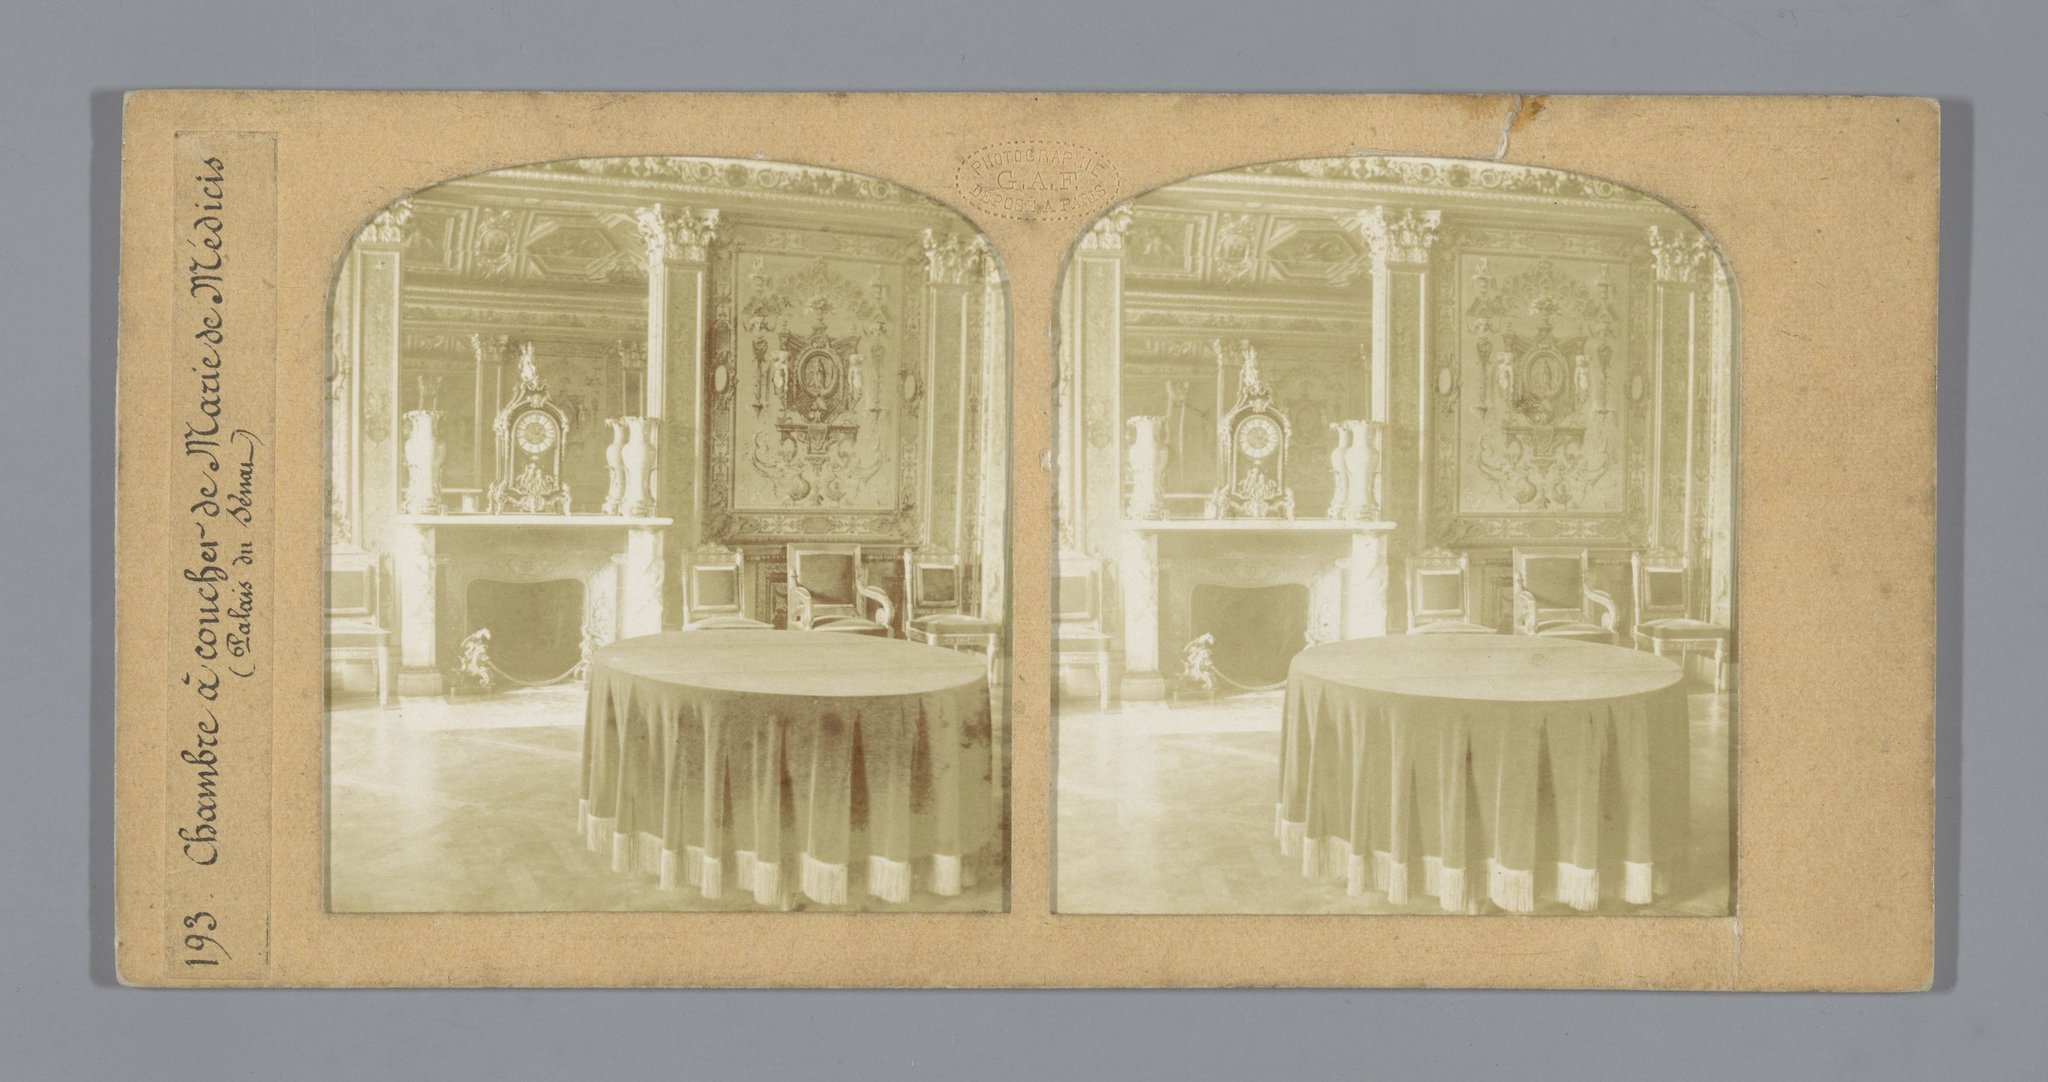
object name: tissue stereograph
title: Chambre à coucher de Marie de Médicis (Palais du Sénat)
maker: florent grau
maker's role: manufacturer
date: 1859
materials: cardboard, paper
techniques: albumen print, hand coloring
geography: paris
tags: bedroom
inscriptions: inscription: ‘Déposé a Paris’, number: ‘193’